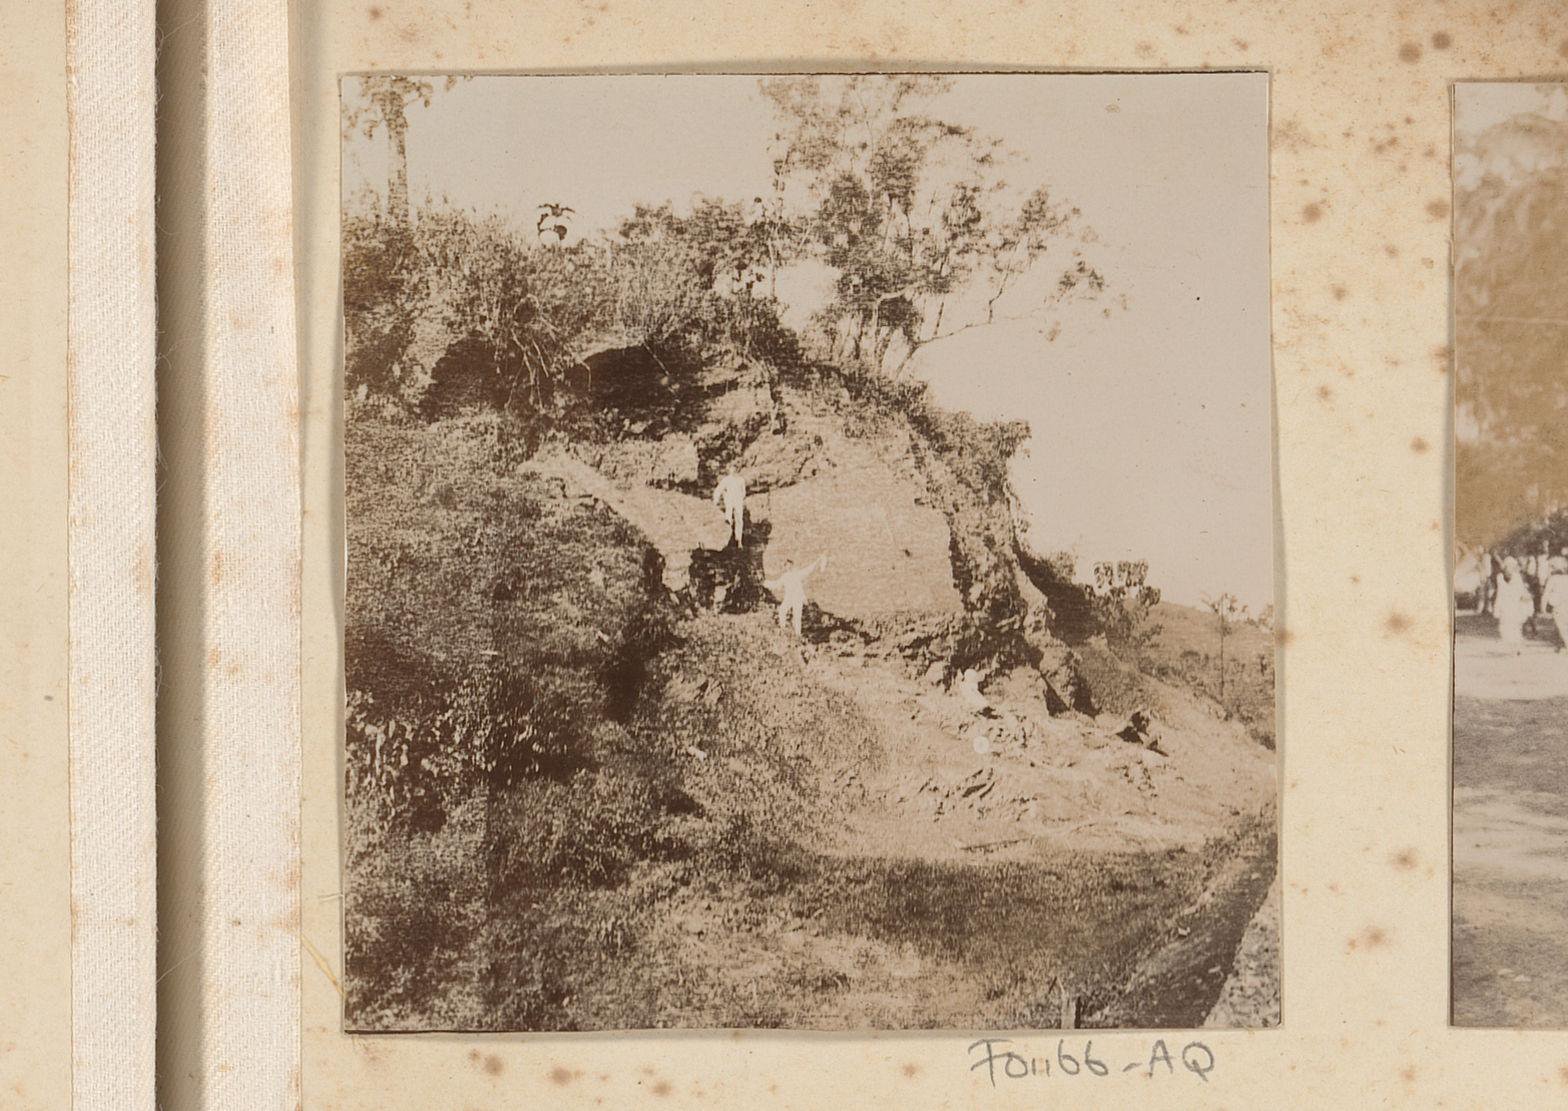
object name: photograph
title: Nederlanders op een rots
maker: Anonymous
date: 1890-1910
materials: photographic support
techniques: gelatin silver print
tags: europeans, historical persons, rocks, dutch east indies, the